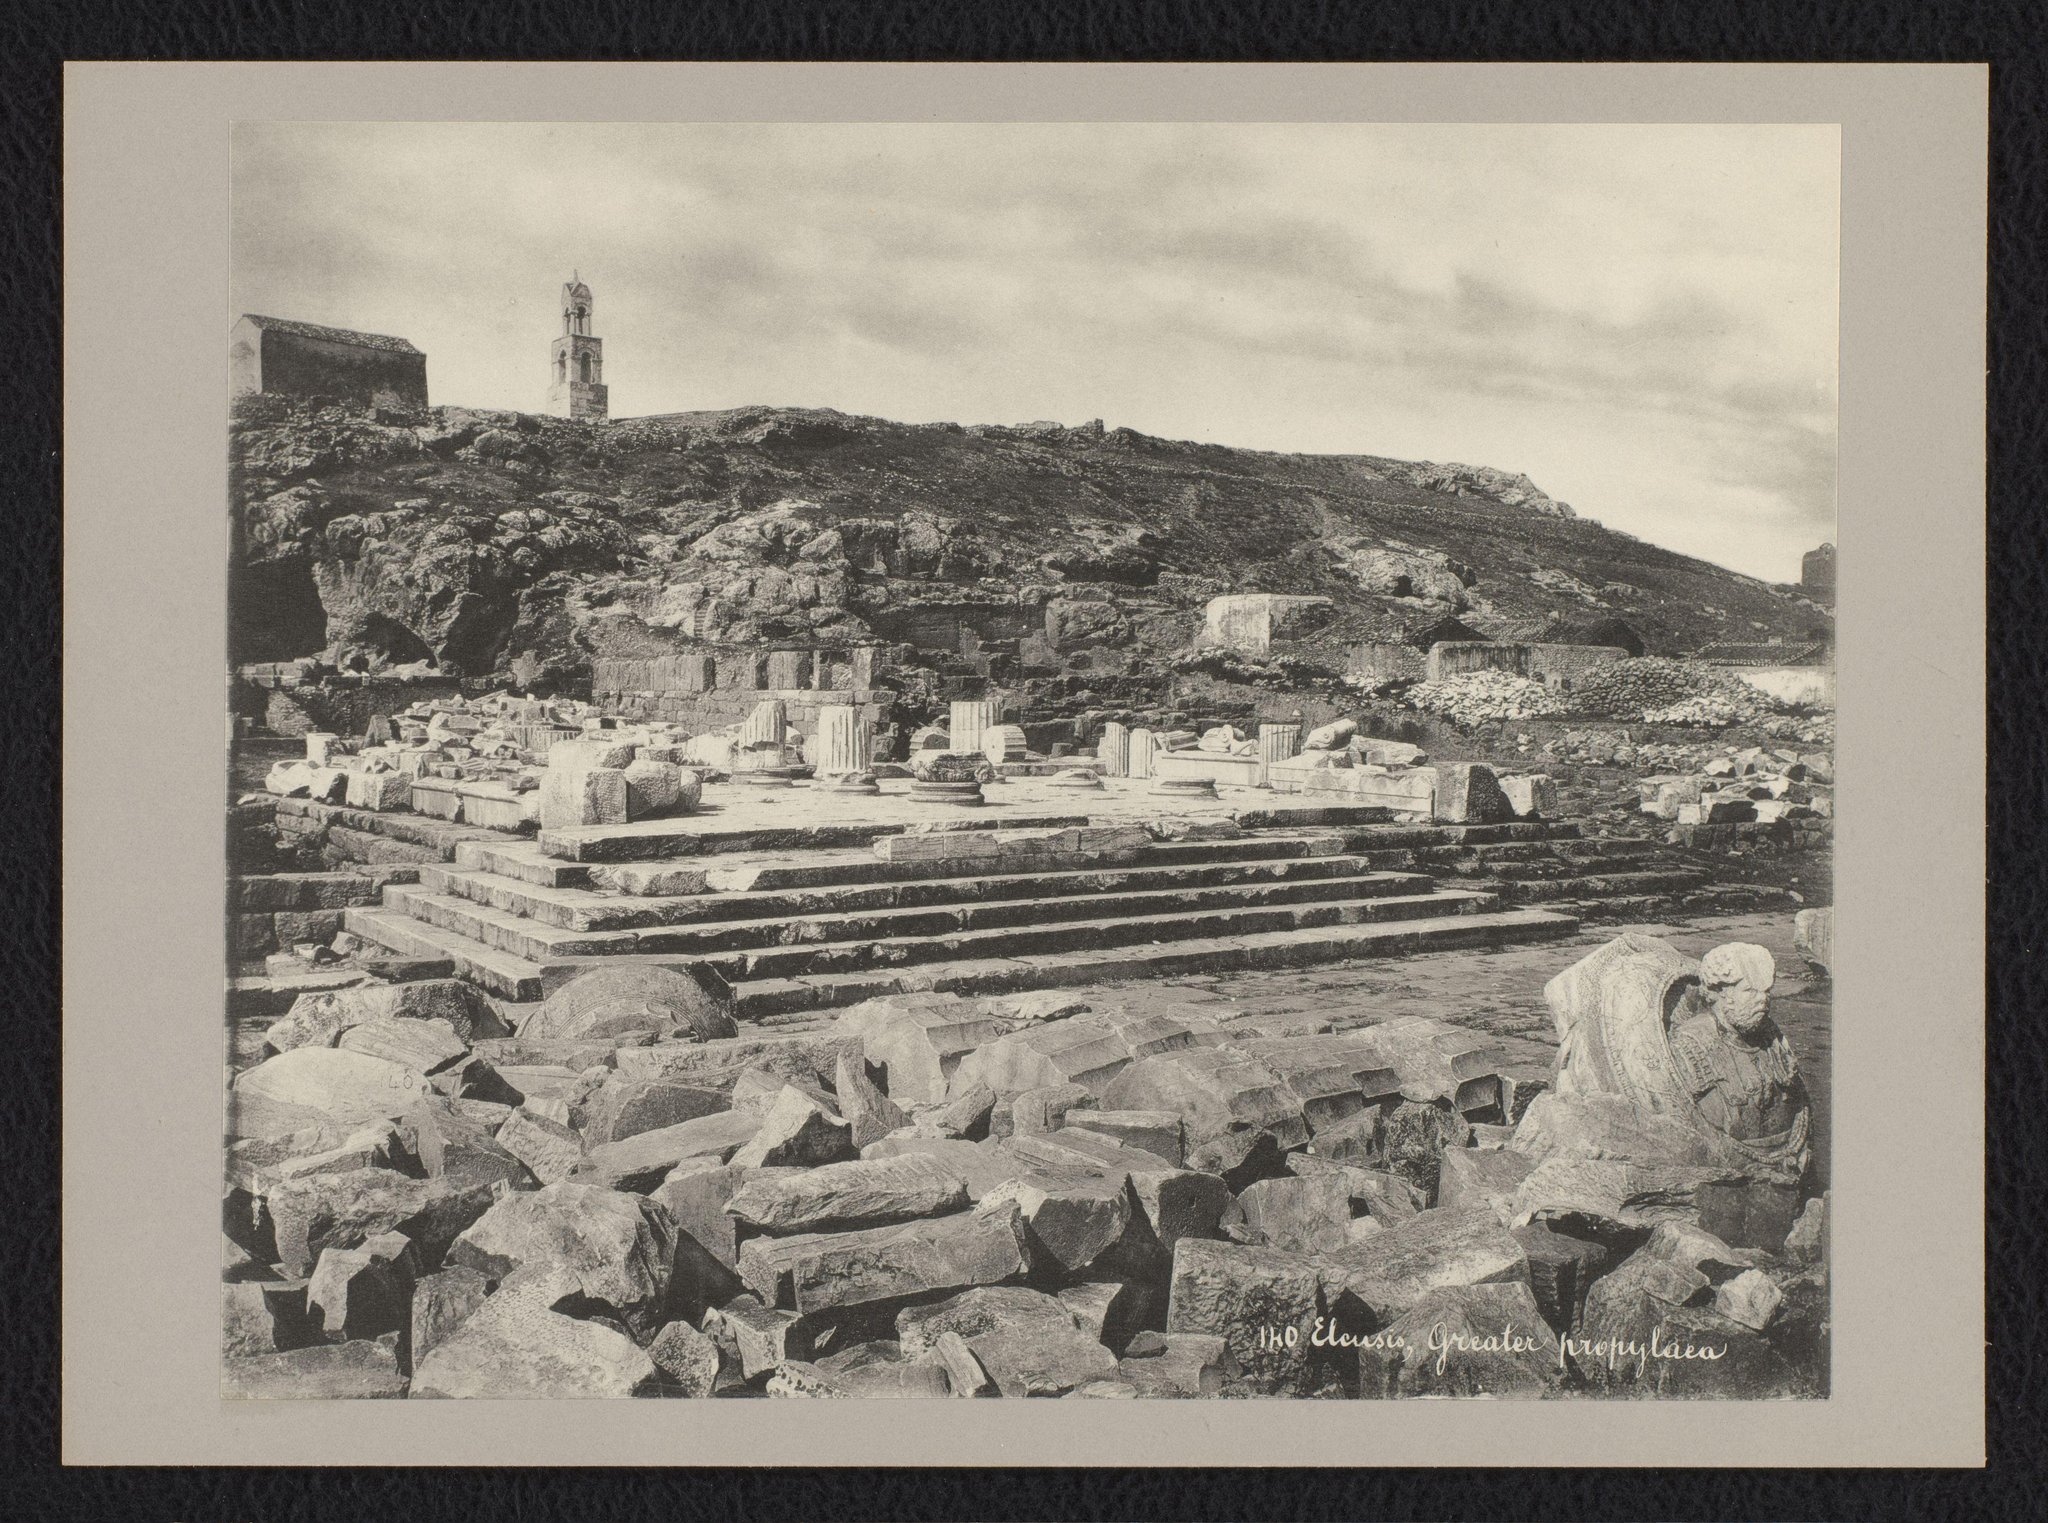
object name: photograph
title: 1h0(?) Eleusis, Greater propylaea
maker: Anonymous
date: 1895-1915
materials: cardboard, paper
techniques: photograph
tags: attica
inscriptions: annotation: ‘44. Tempel des Mystères.’